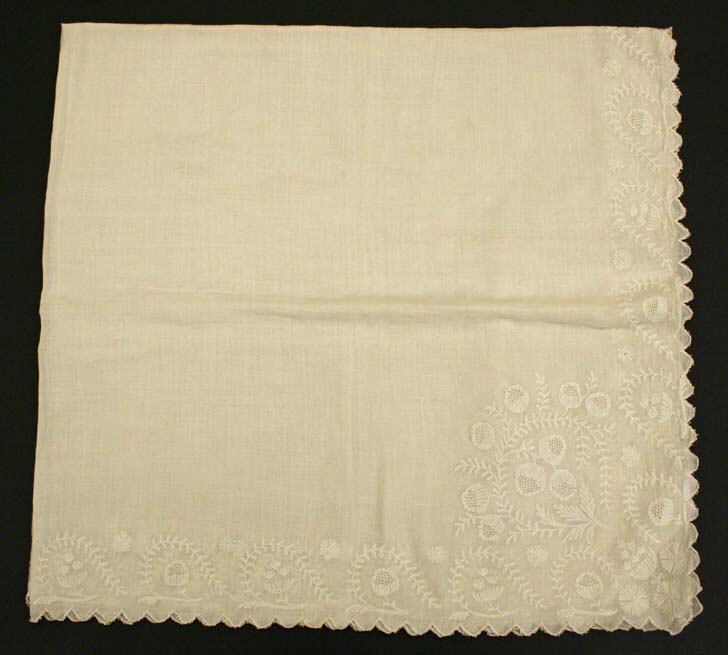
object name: fichu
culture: european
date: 1795-1800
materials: cotton